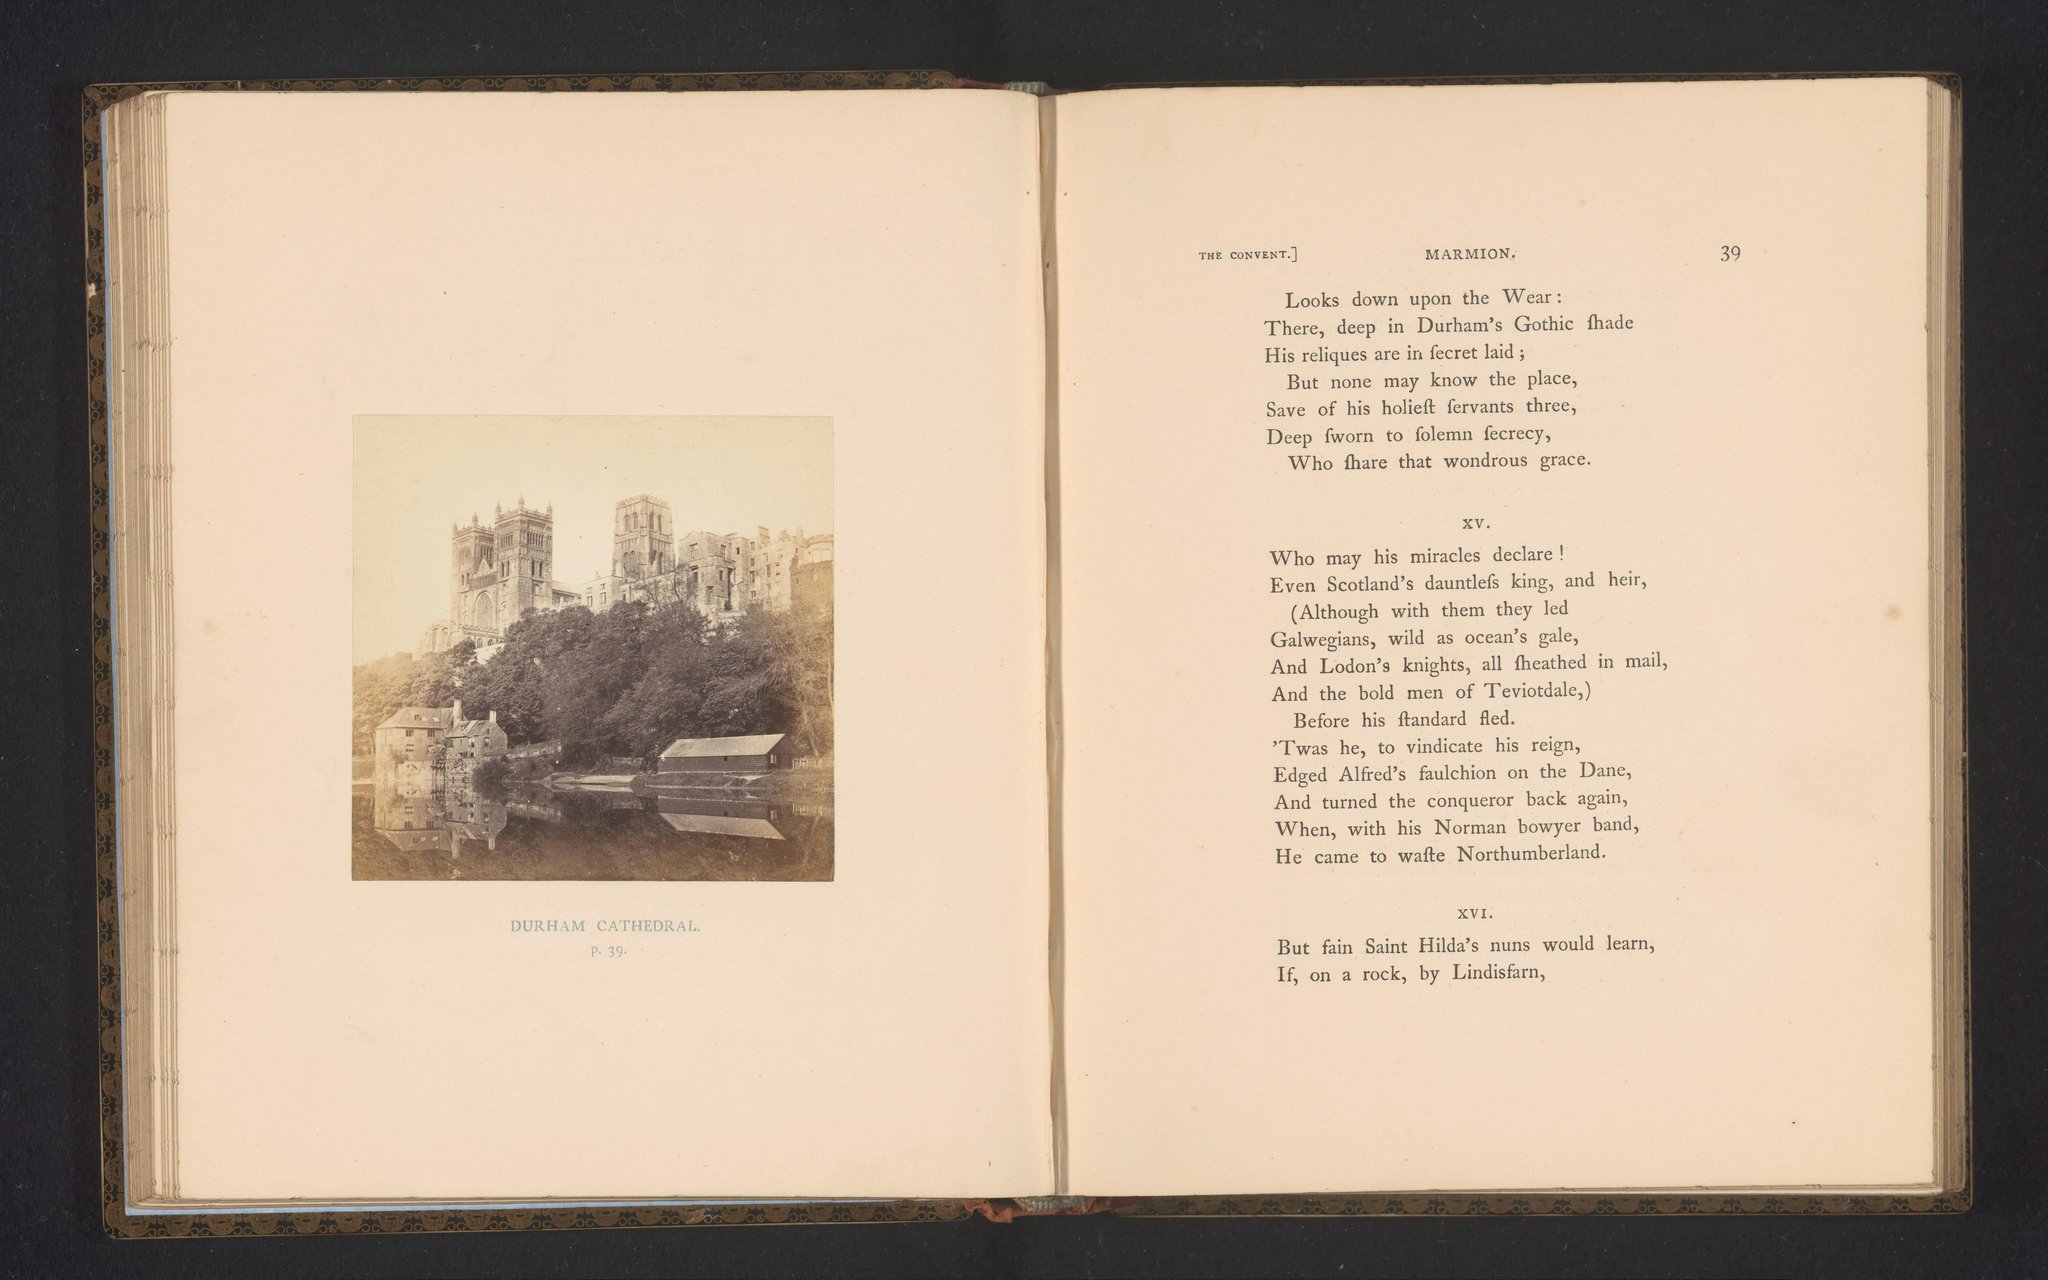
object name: photograph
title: Durham cathedral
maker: thomas annan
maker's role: fotograaf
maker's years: 1829-1887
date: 1856-1866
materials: photographic support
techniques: albumen print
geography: durham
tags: river, church (exterior), façade (of house or building)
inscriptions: inscription: ‘p. 39.’